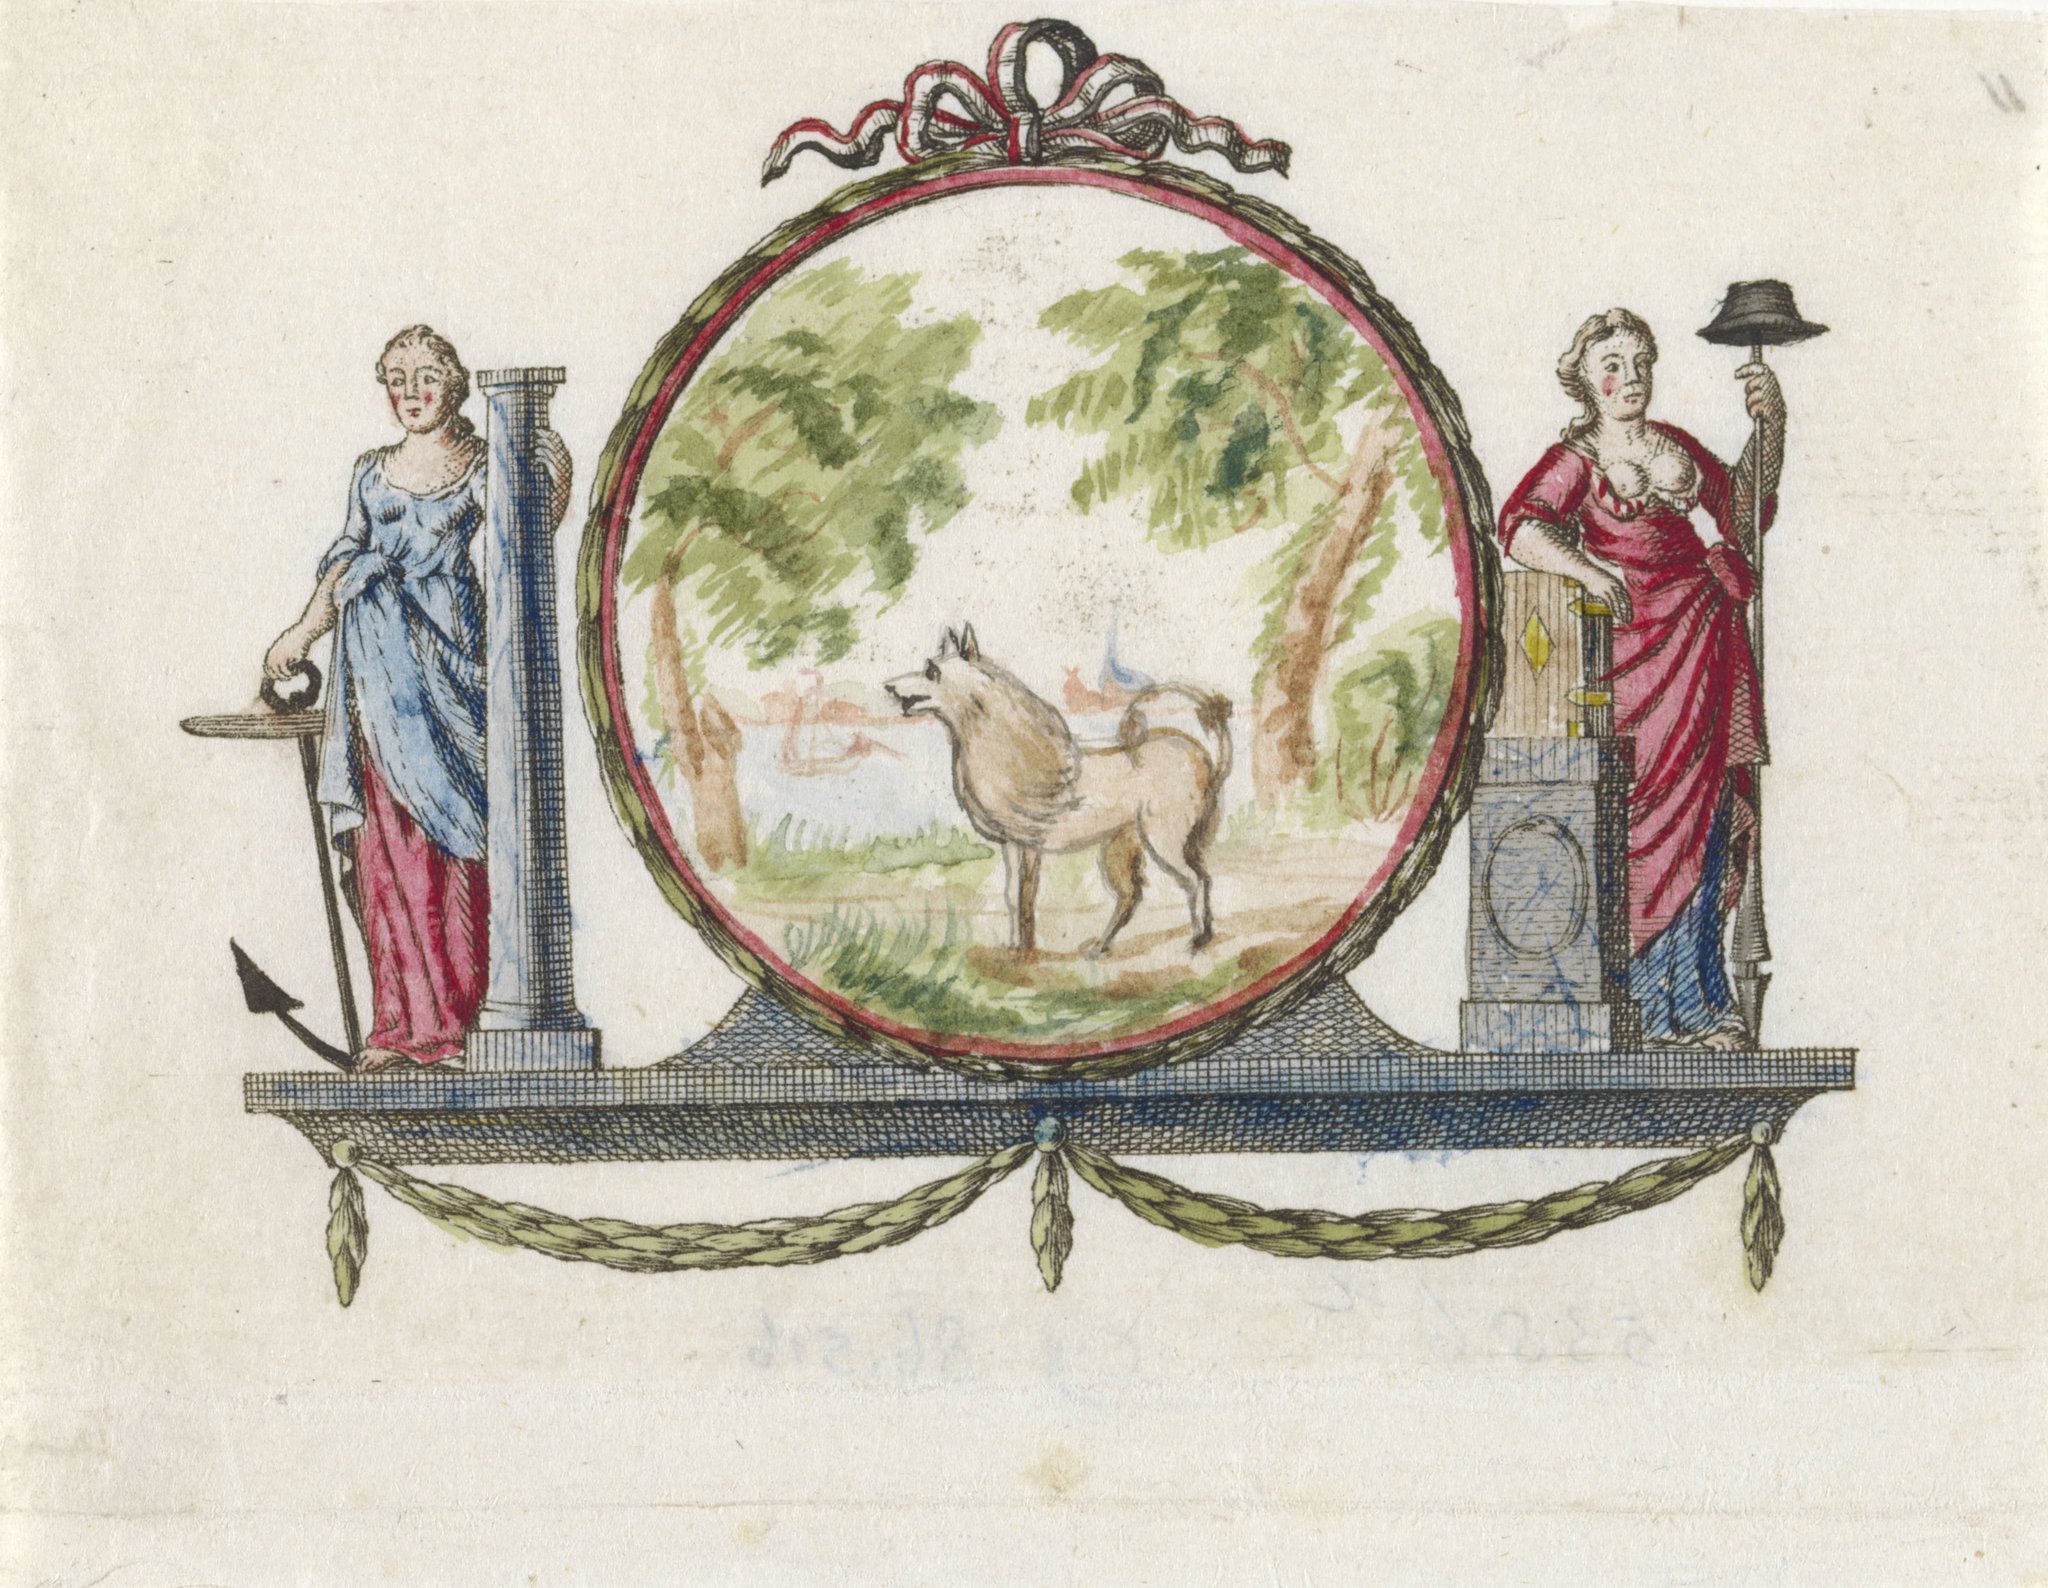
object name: print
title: Vignet met keeshond, 1795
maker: Anonymous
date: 1795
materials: paint, paper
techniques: brush, engraving, etching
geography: netherlands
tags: fortitude, 'fortitudo' ~ one of the four cardinal virtues, hope, 'spes'; 'speranza divina e certa' (ripa) ~ one of the three theological virtues, dog, freedom, liberty; 'libertà' (ripa) (+ abstract concept represented by female figure)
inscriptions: collector's mark: Lugt 2228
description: Rond vignet met aan weerszijden de staande Hoop / Kracht en Vrijheid, 1795. In het medaillon is een keeshond in een landschap getekend.